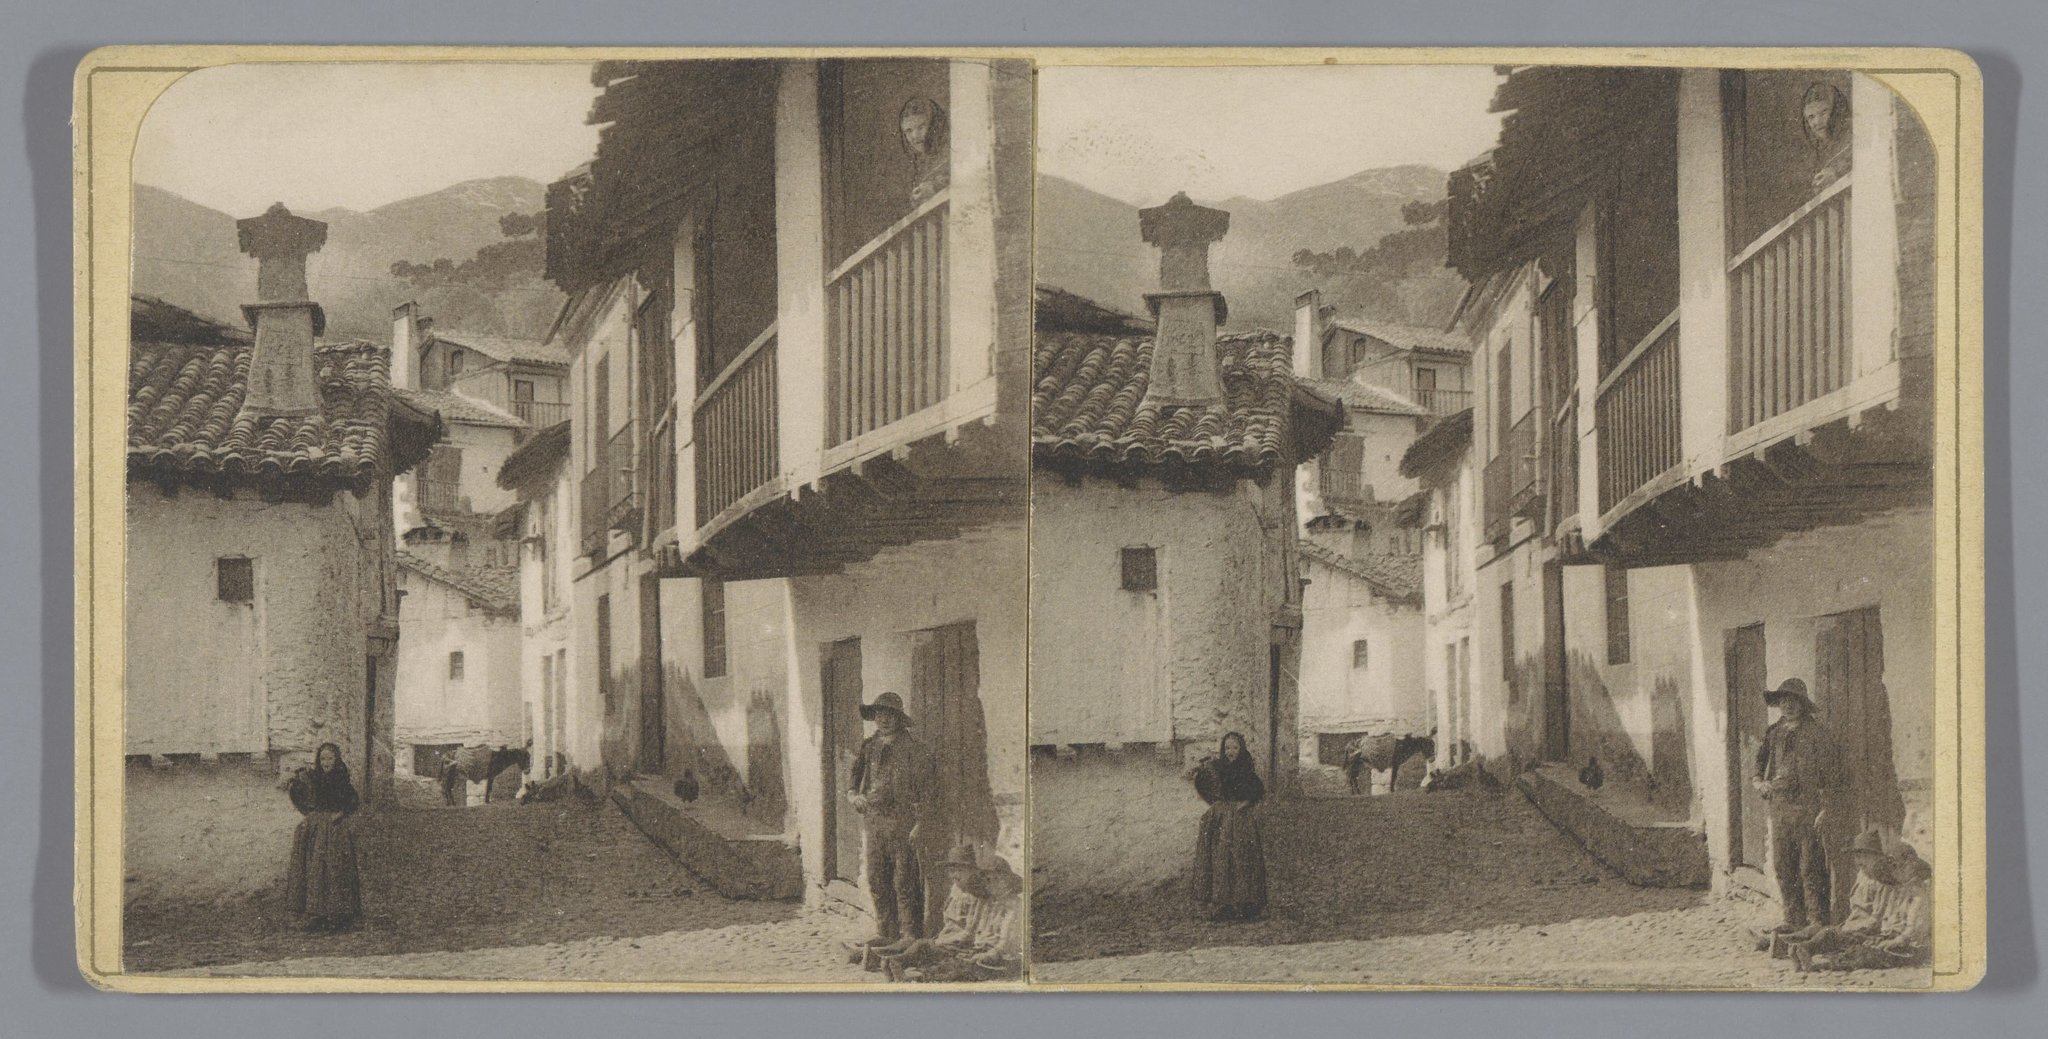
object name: stereograph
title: Gezicht op een straat te Guisando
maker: Anonymous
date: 1890-1920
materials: cardboard, paper, ink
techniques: photograph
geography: guisando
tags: street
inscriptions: inscription: ‘Sierra de Gredos. (Ávila) Una calle de Guisando.’